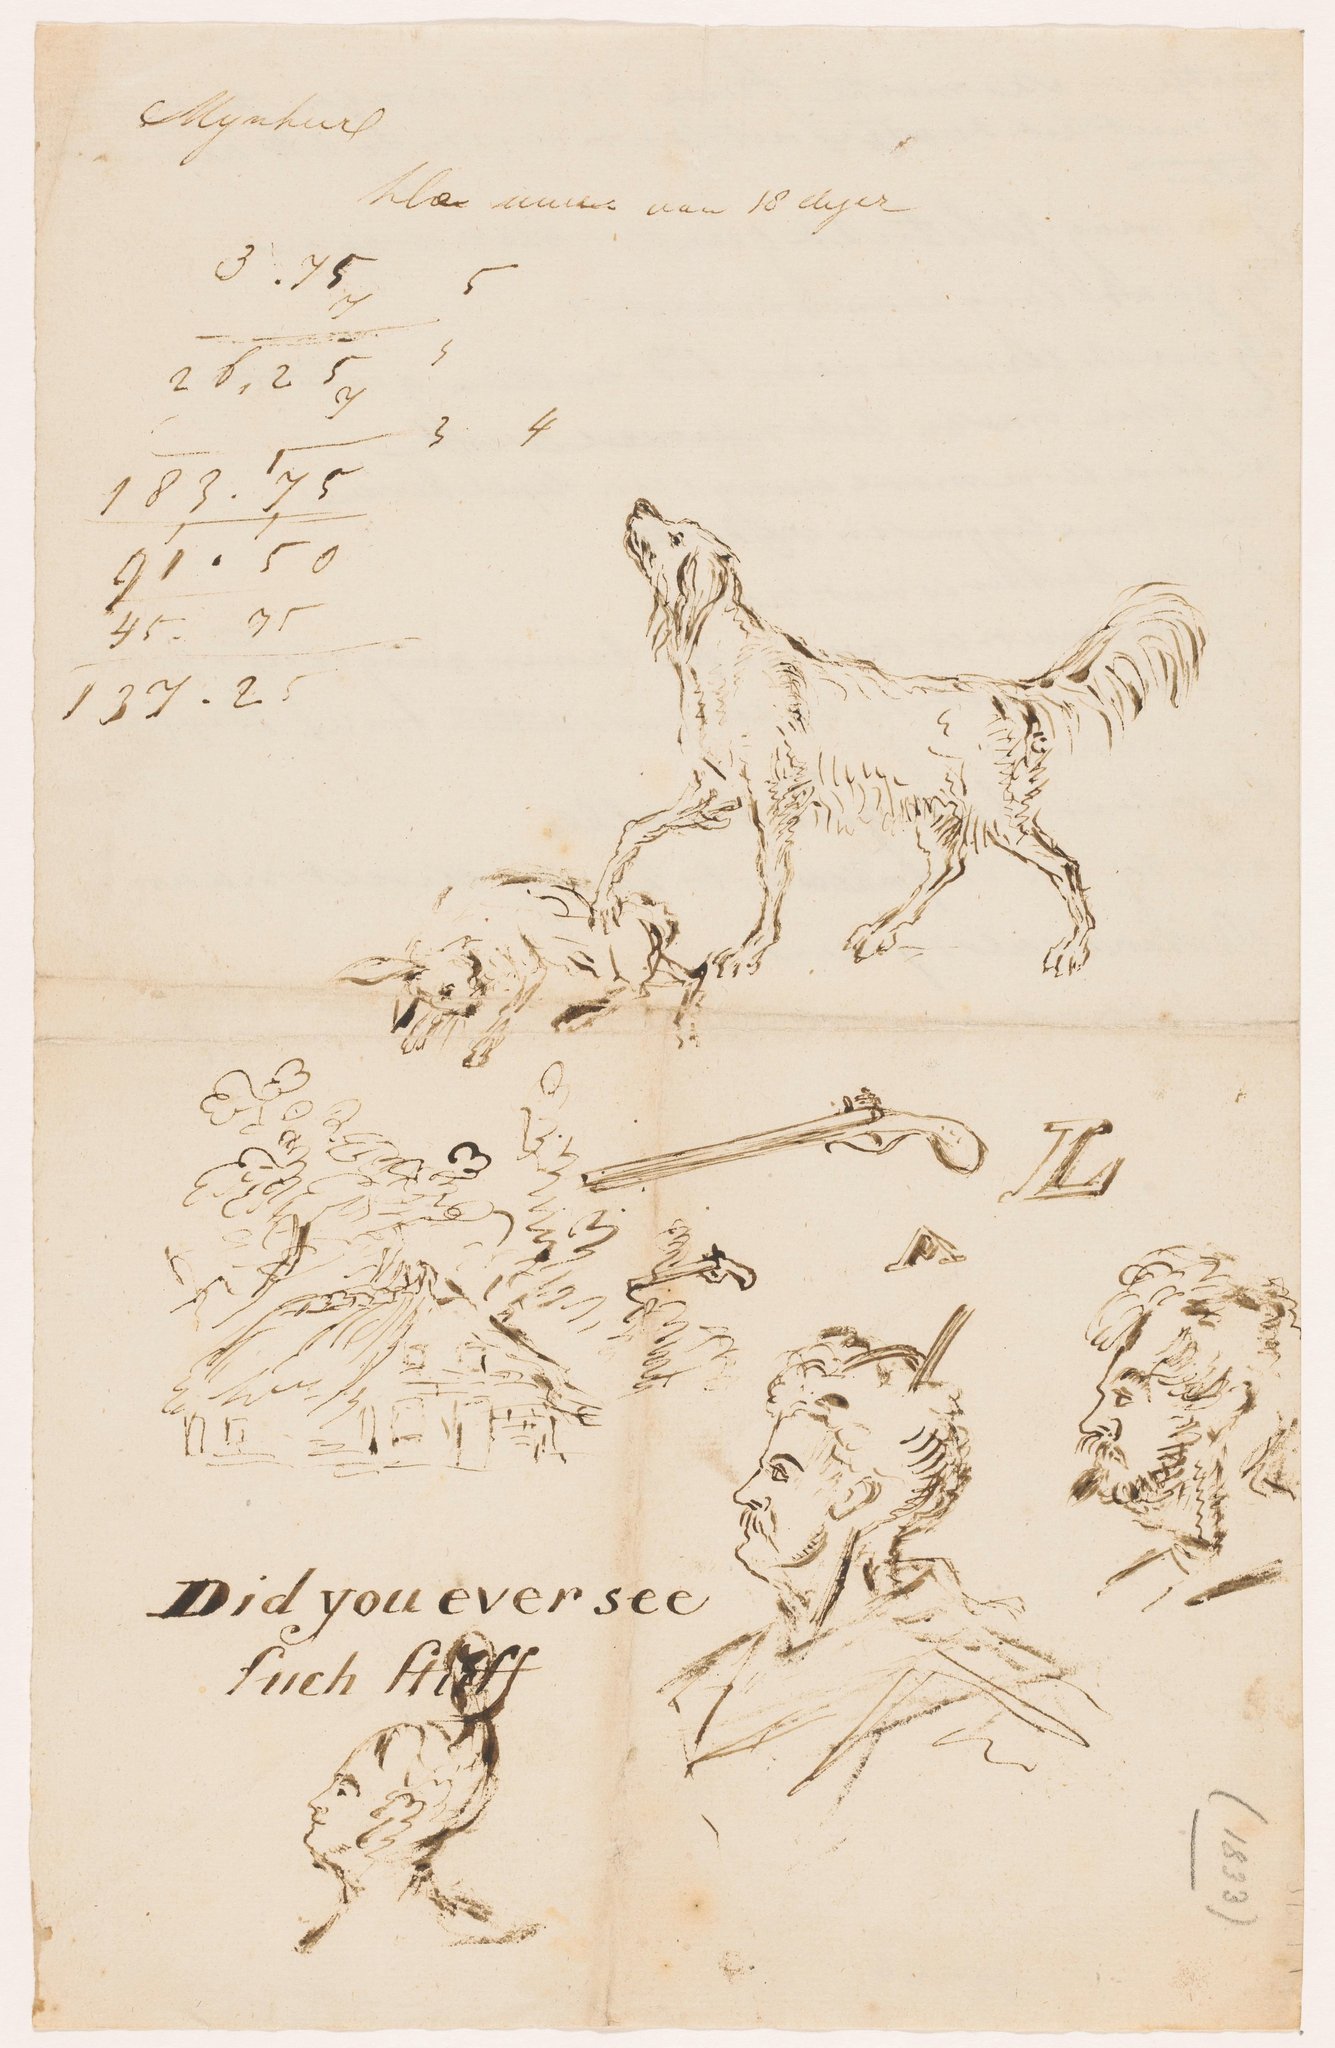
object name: drawing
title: Studies van koppen, een jachthond, een huisje en pistolen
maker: johannes tavenraat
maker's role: draughtsman, painter, print maker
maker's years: 1809-1881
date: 1830-1835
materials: ink, paper, pencil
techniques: pen, writing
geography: netherlands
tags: firearms (with name), hunting dogs beside the spoils, dog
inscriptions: date: ‘1833’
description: Studieblad met koppen, een jachthond bij een dode haas, een huisje en pistolen. Links bovenaan het begin van een brief en een rekensom; links onderaan: 'Did you ever see such stuff'. Op de achterzijde schrijfoefeningen, tekst in potlood.